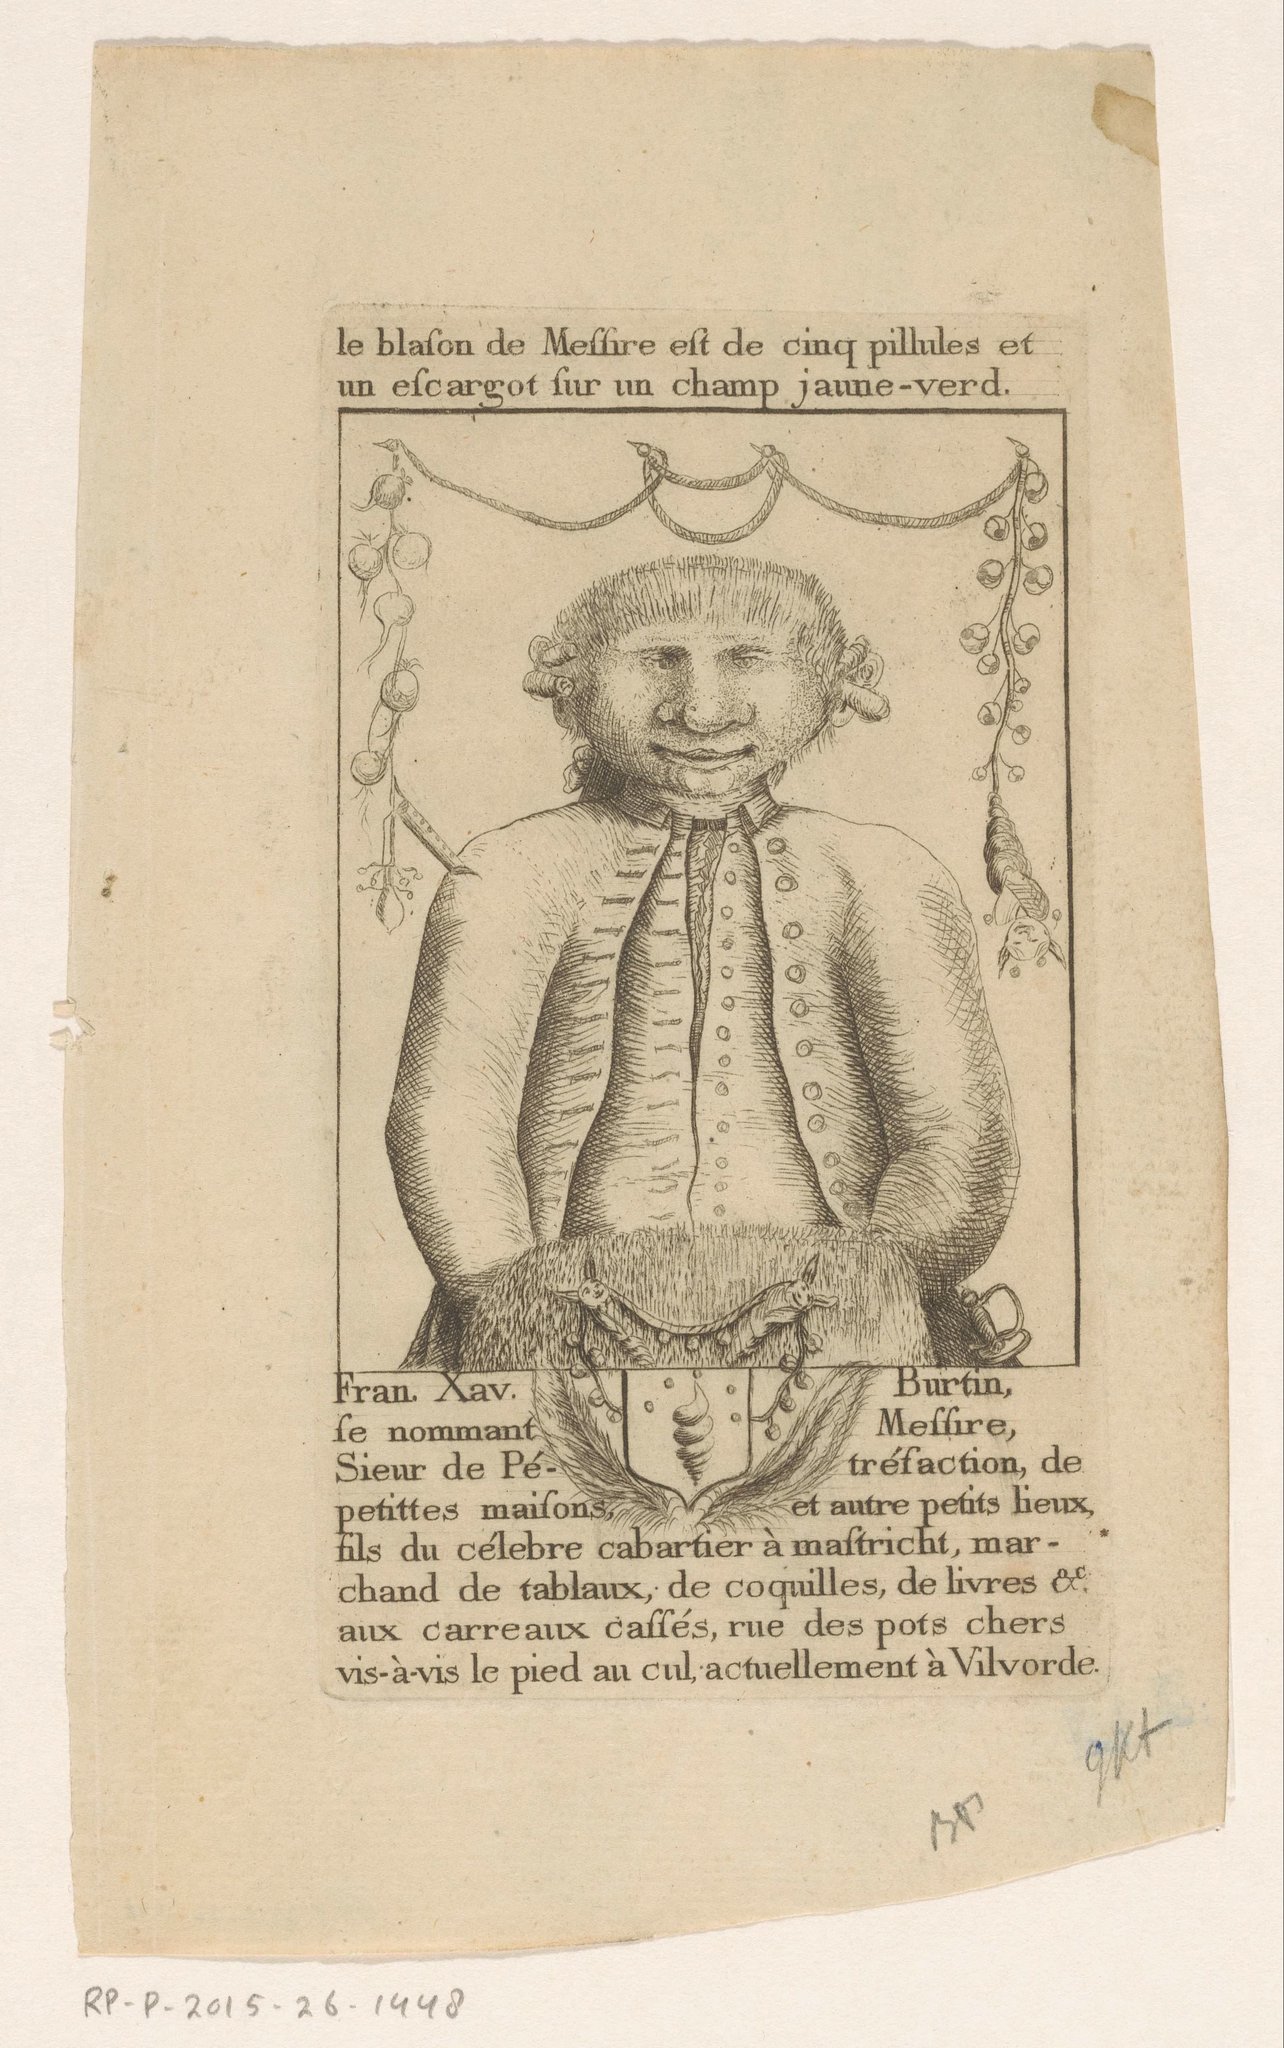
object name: print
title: Portret van François Xavier de Burtin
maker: Anonymous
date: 1790-1798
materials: paper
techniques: etching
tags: maastricht, brussels, françois xavier de burtin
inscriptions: watermark, collector's mark, collector's mark: Lugt 2228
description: Portret van de arts, mineraloog en verzamelaar François Xavier de Burtin. Met boven de afbeelding een beschrijving van diens wapen en achtregelig onderschrift in het Frans.